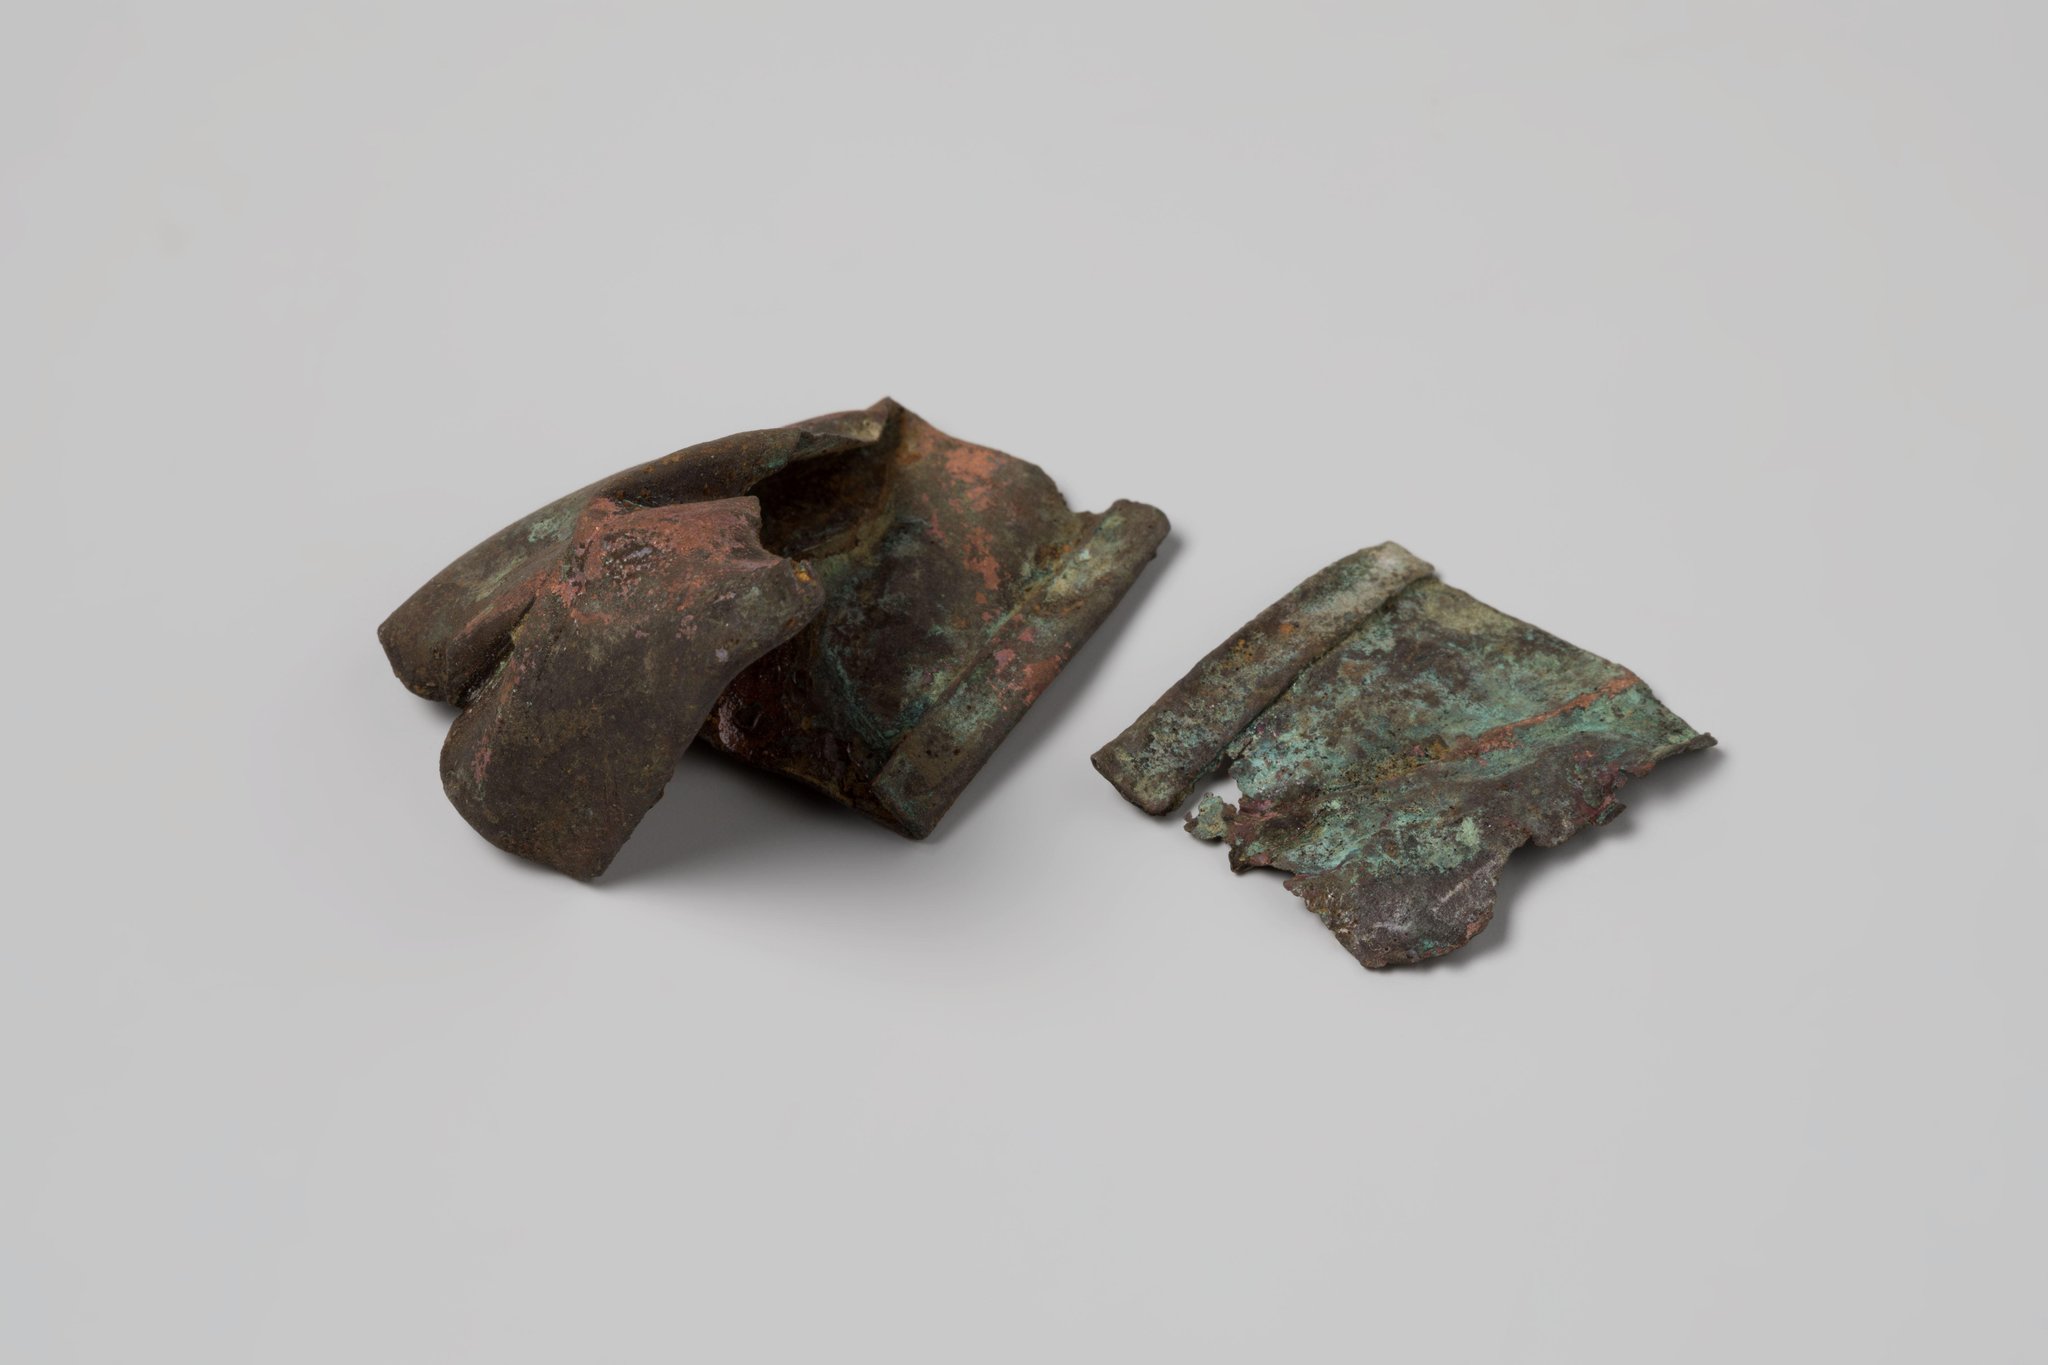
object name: beslag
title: Fragmenten beslag uit het wrak van de Oost-Indiëvaarder Hollandia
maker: Anonymous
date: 1700-1743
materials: copper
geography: netherlands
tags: verenigde oostindische compagnie, hollandia (schip), annet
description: Fittings, bands and bracing, flat; id. NG 1980-27H3053, squashed.